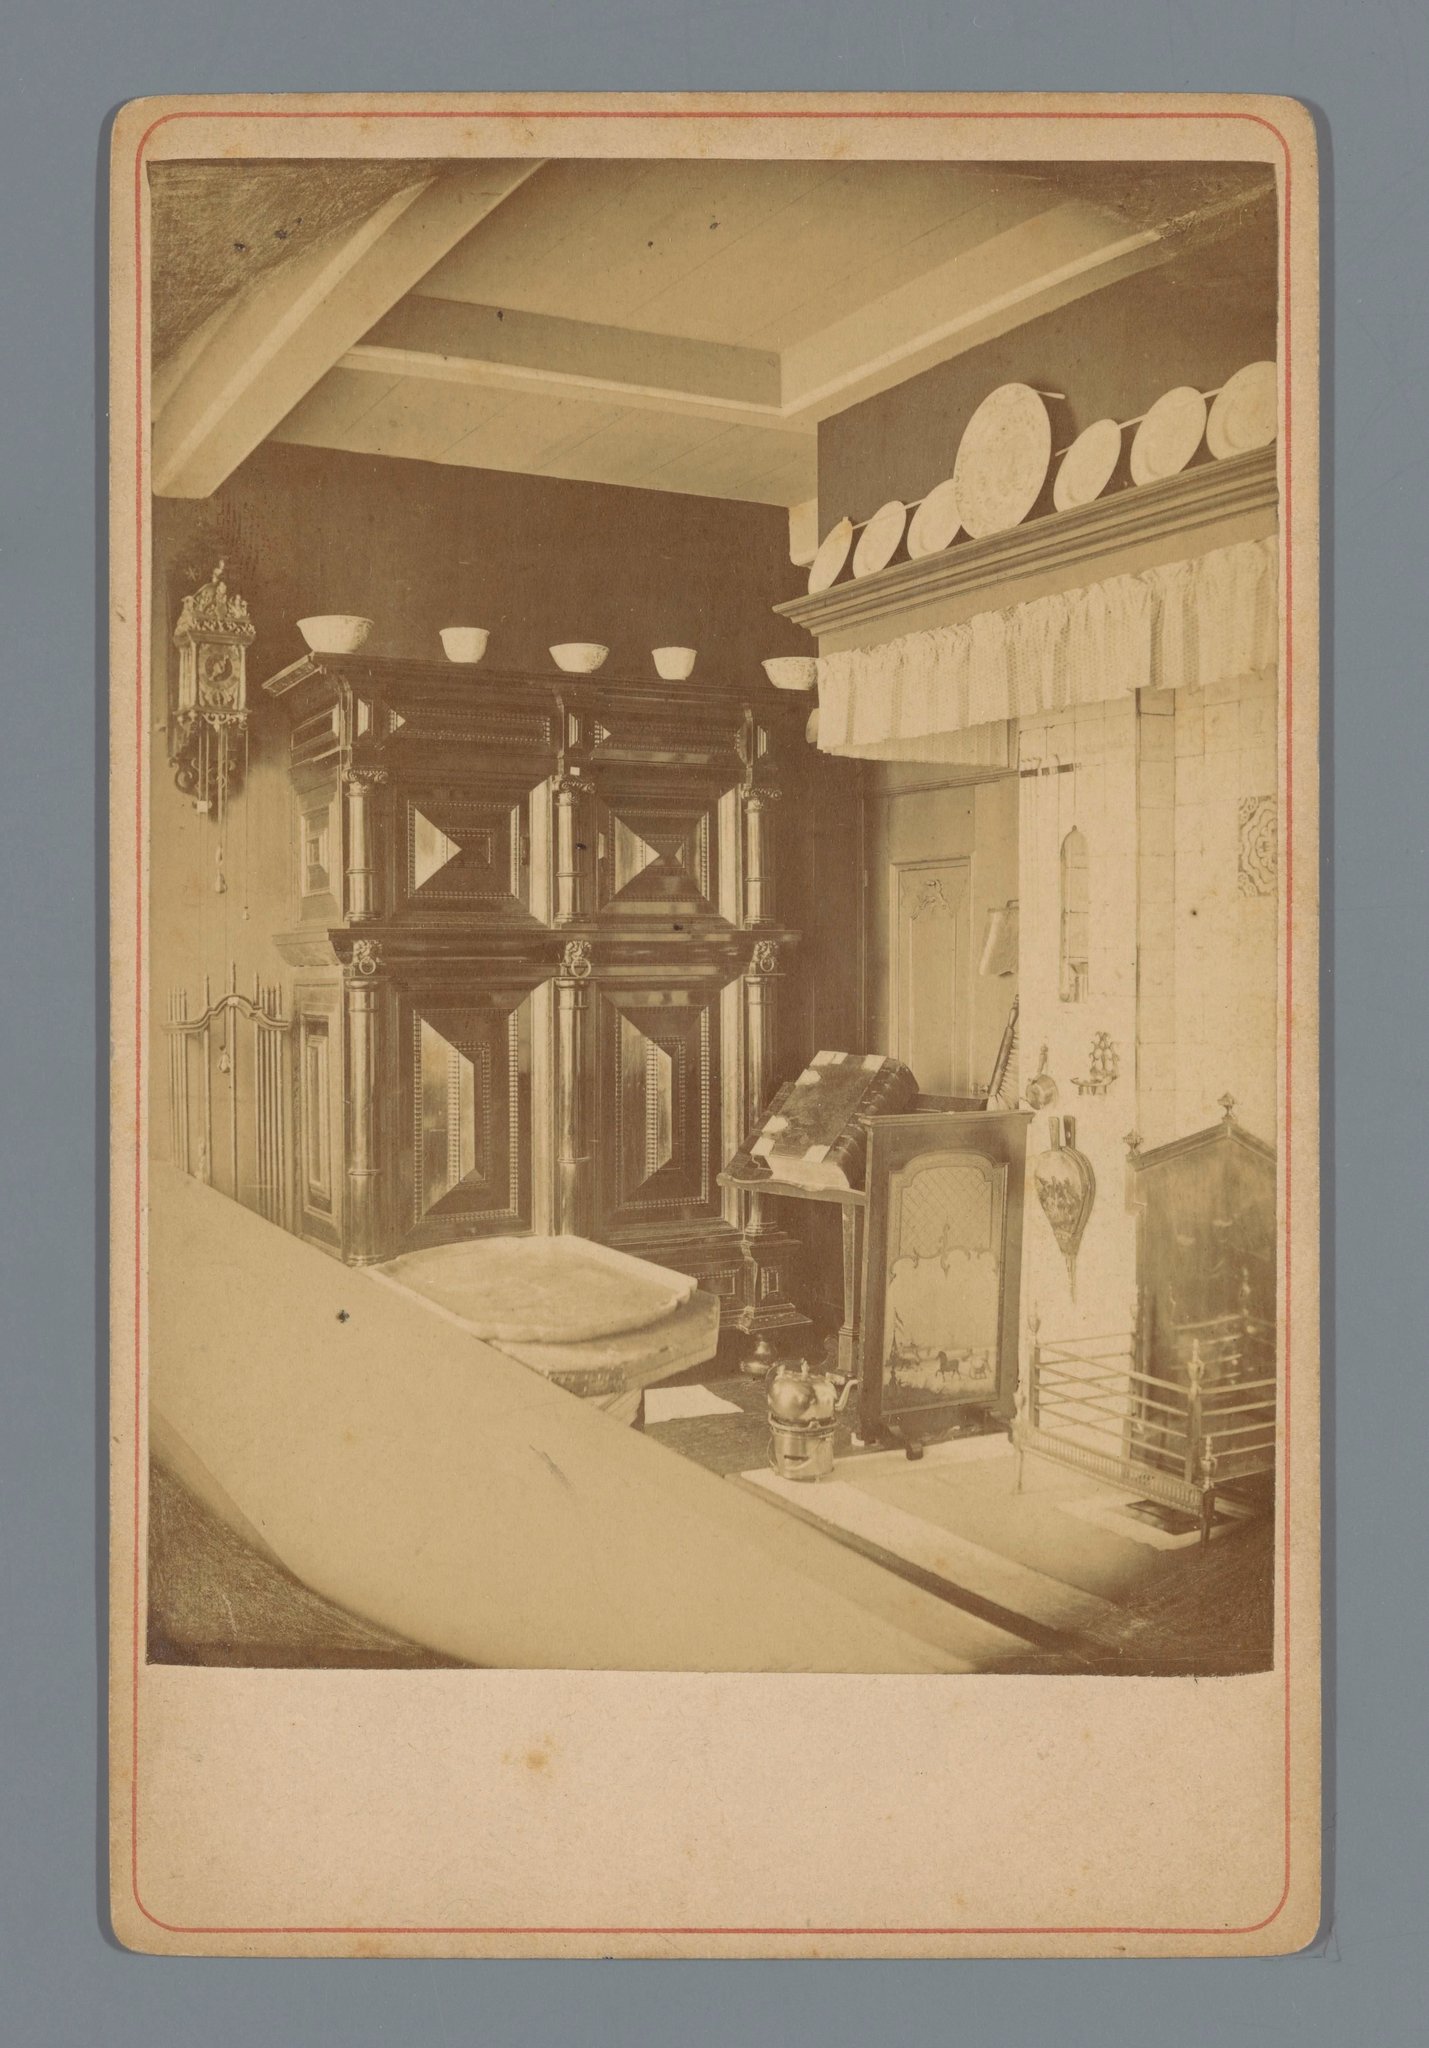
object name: cabinet photograph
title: België, stijlkamer in een museum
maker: Anonymous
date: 1850-1900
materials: cardboard, photographic support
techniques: albumen print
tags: interior of the house, belgium